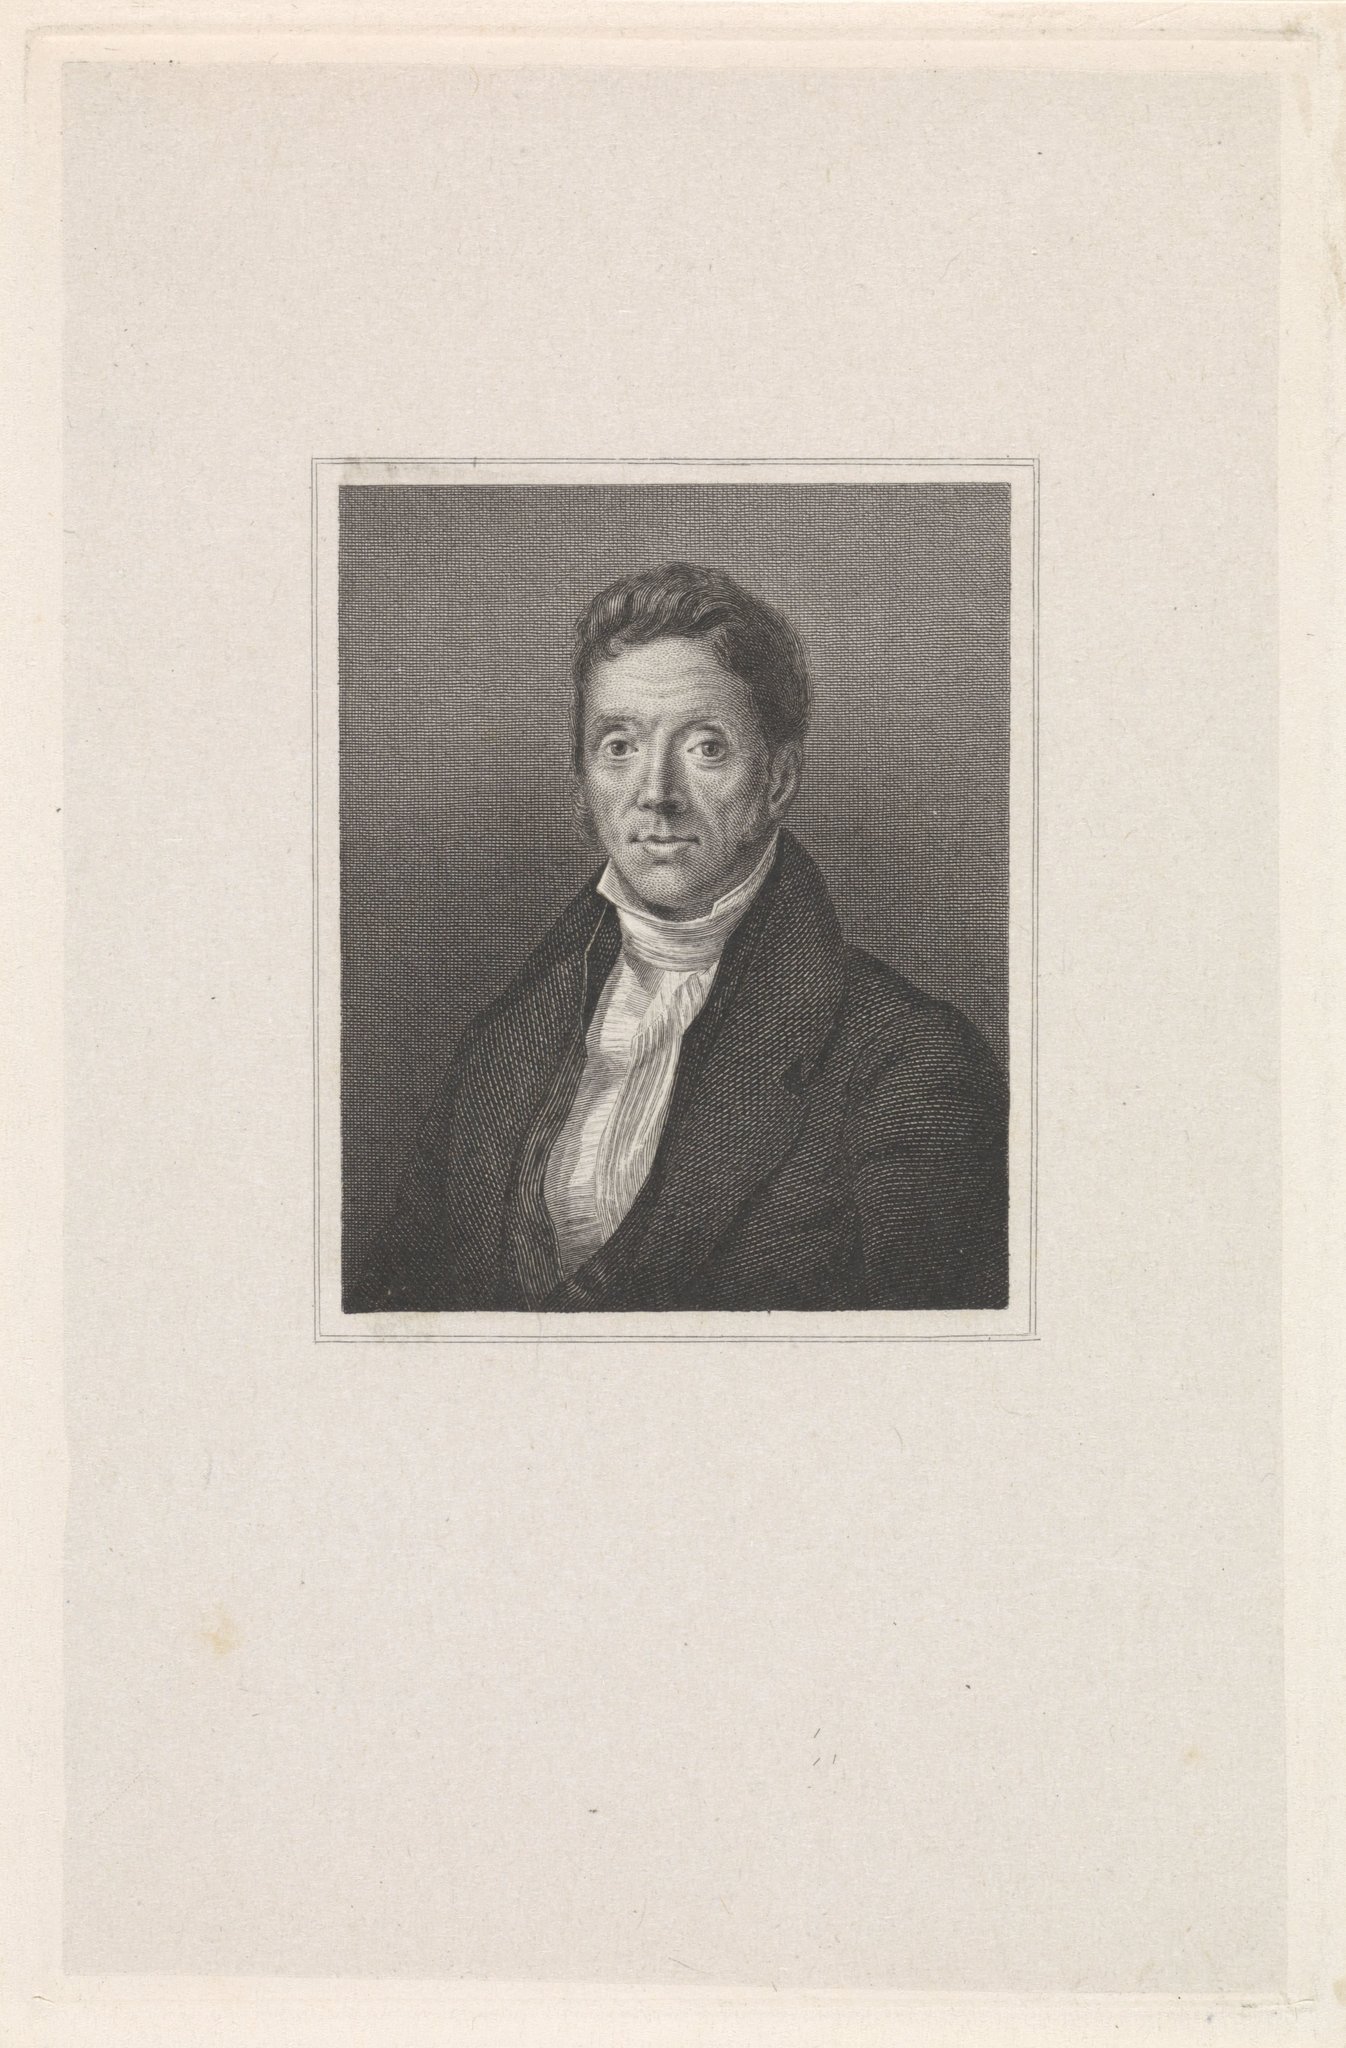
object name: print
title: Portret van Frans van der Breggen Cornzn.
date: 1817-1851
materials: paper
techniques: engraving, etching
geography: netherlands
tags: leiden, amsterdam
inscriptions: collector's mark: Lugt 2228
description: Portret van Frans van der Breggen Cornzn., hoogleraar geneeskunde.